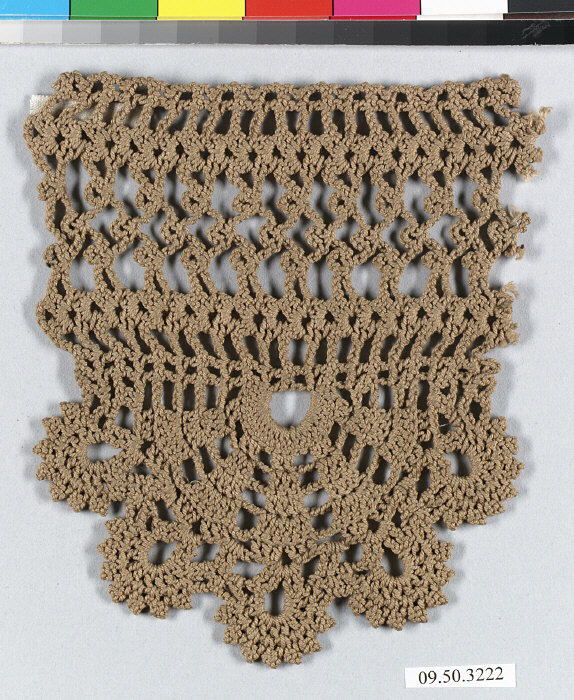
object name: sample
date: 1801-1900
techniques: crochet